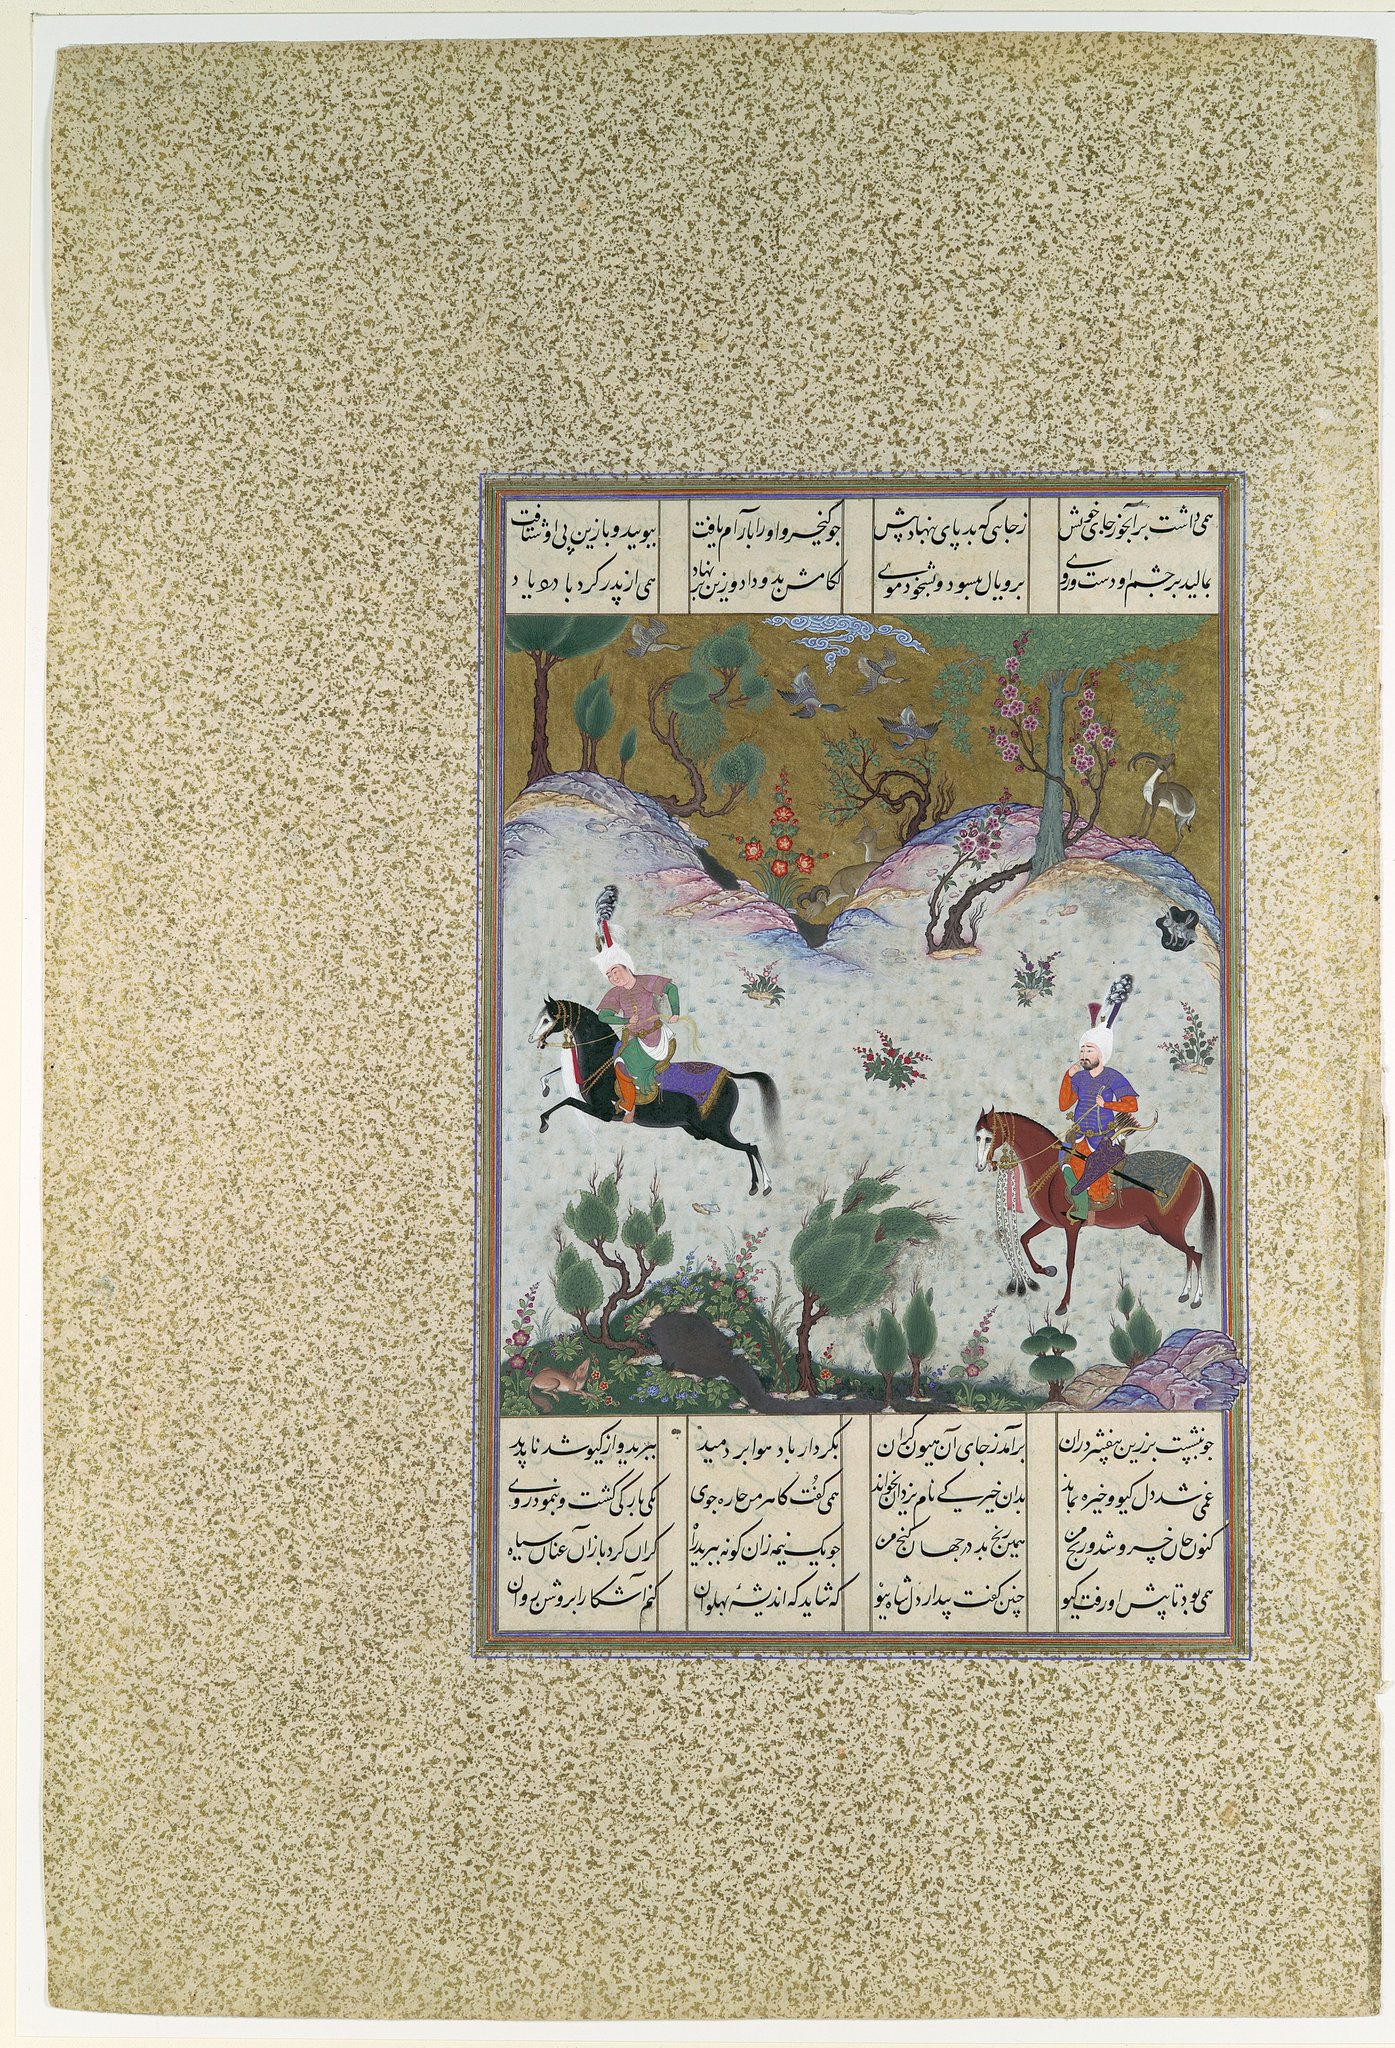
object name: folio from an illustrated manuscript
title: "Kai Khusrau Rides Bihzad for the First Time", Folio 212r from the Shahnama (Book of Kings) of Shah Tahmasp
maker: abu'l qasim firdausi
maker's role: author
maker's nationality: iranian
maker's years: 935-1020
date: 1525-1530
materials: gold, ink, paper, silver, watercolor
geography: iran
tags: birds,men,horses